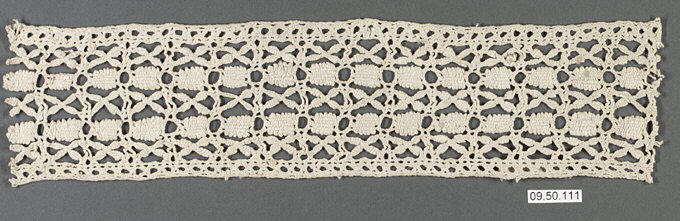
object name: strip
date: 1701-1733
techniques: lace